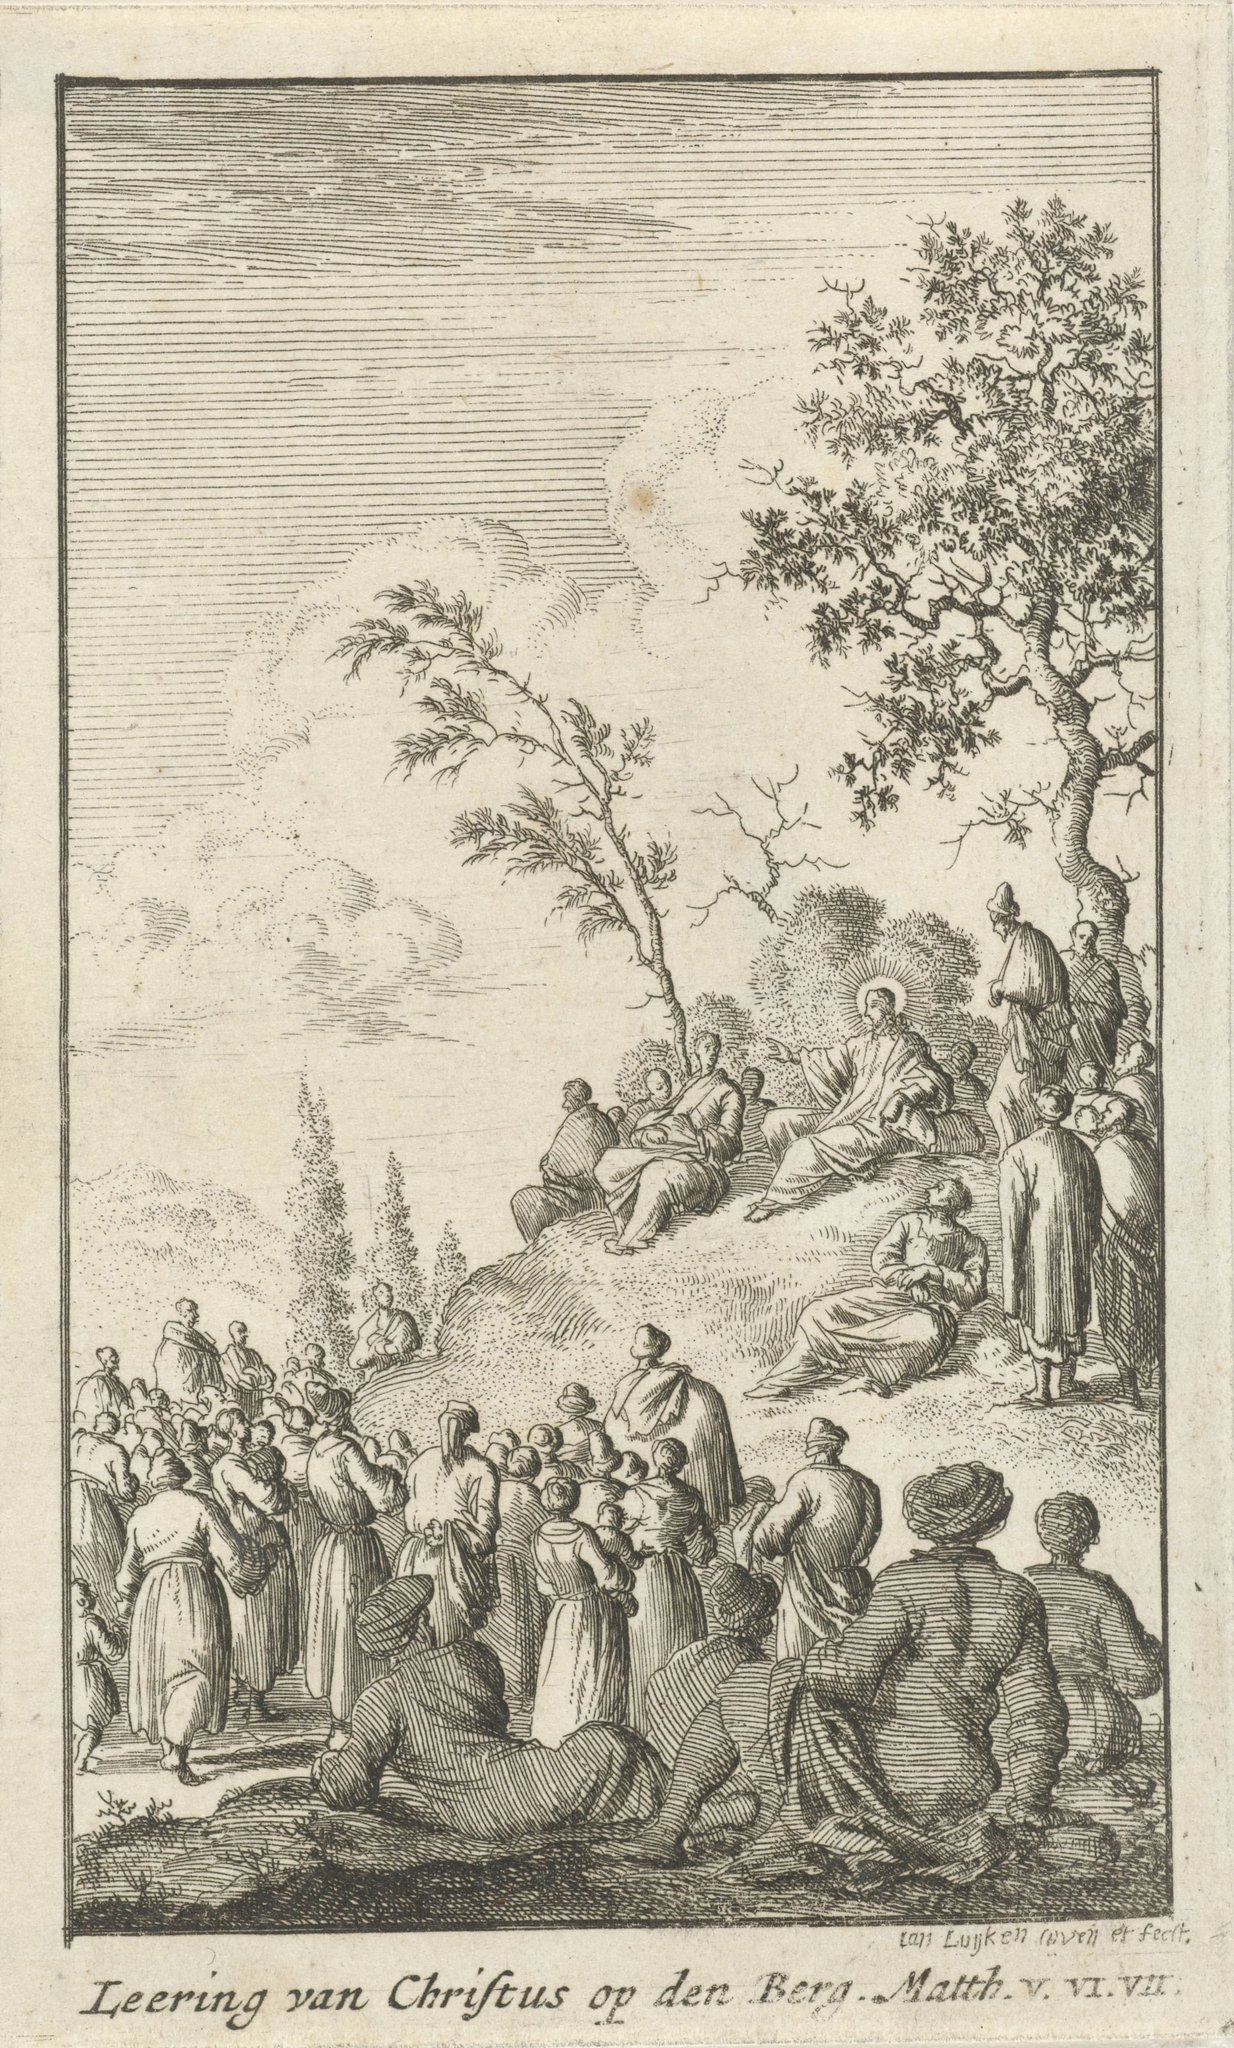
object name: print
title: Vierentwintig scènes uit het Nieuwe Testament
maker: jan luyken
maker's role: draughtsman, print maker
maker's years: 1649-1712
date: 1681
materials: paper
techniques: etching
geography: amsterdam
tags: 'command these stones to become loaves of bread' ~ temptation of christ in the wilderness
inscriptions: collector's mark: Lugt 2228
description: Twintig prenten van deze serie (waaronder de hier besproken prent) verschenen mogelijk voor het eerst in: Het Nieuwe Testament ofte alle Boecken des Nieuwen Verbondts onses Heeren Iesu Christi. Amsterdam: Hieronymus Sweerts, Jan ten Hoorn, Jan Bouman en Daniel van den Dalen, 1681. De complete vierentwintigdelige serie prenten is opgenomen in: Het Nieuwe Testament ofte alle Boecken des Nieuwen Verbondts onses Heeren Iesu Christi. Dordrecht: Pieter en Jacob Keur, 172X (niet voor 1727). De prenten werden, hetzij alle tezamen, hetzij gedeeltelijk, veel gebruikt tot versiering van Nieuwe Testamenten en verschenen tevens in kopie.